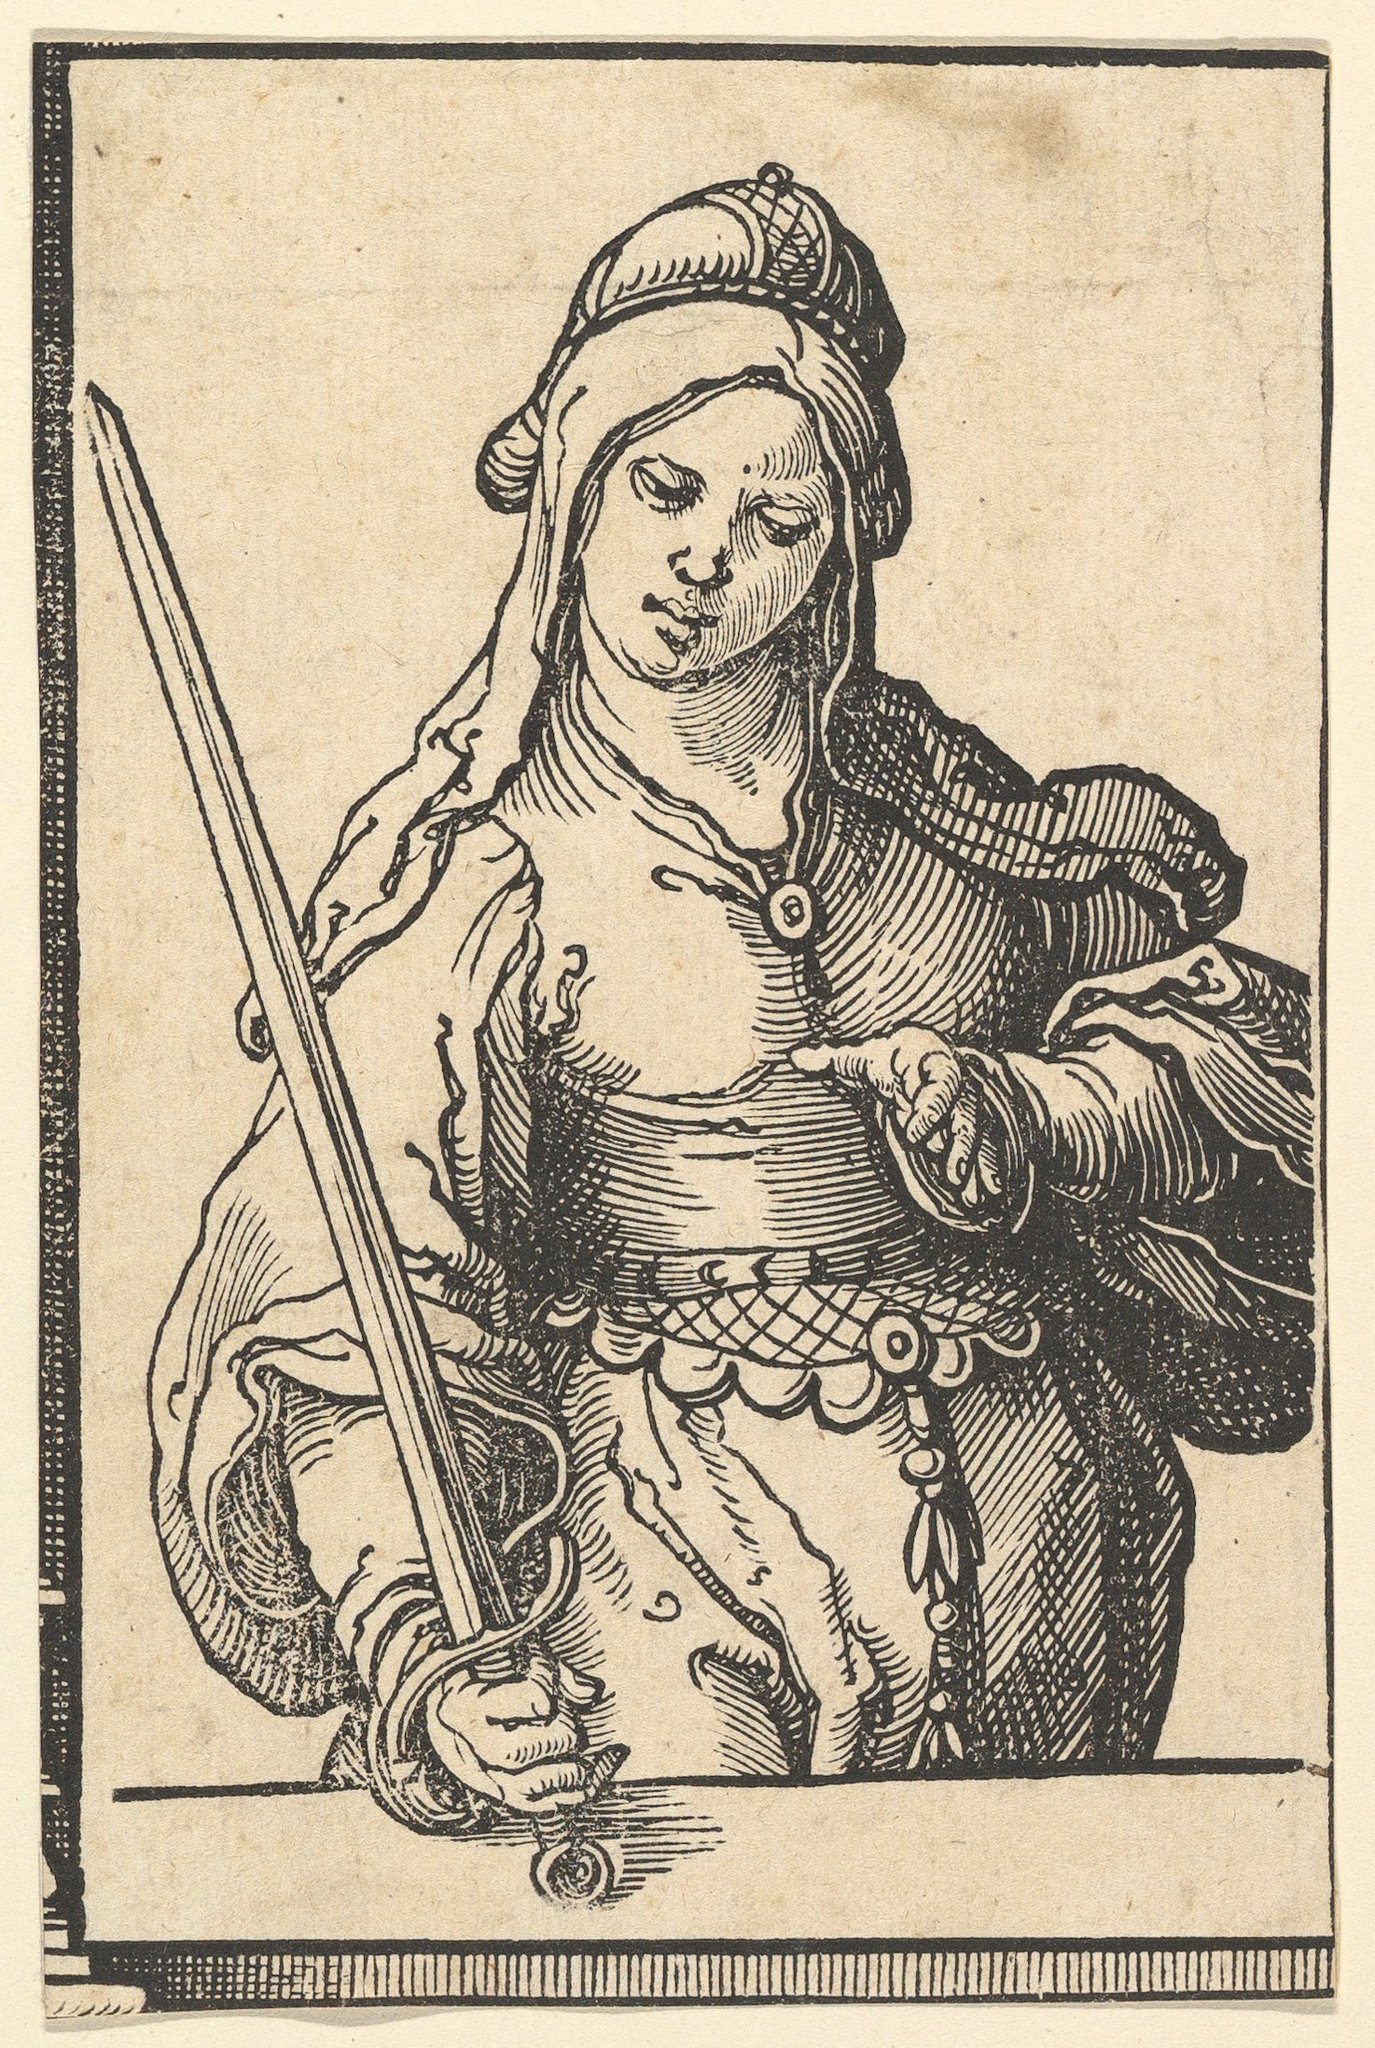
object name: print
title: European Sibyl, from the series of Sibyls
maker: lucas van leyden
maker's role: artist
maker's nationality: netherlandish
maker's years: 1494-1533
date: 1530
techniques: woodcut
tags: swords,sibyl